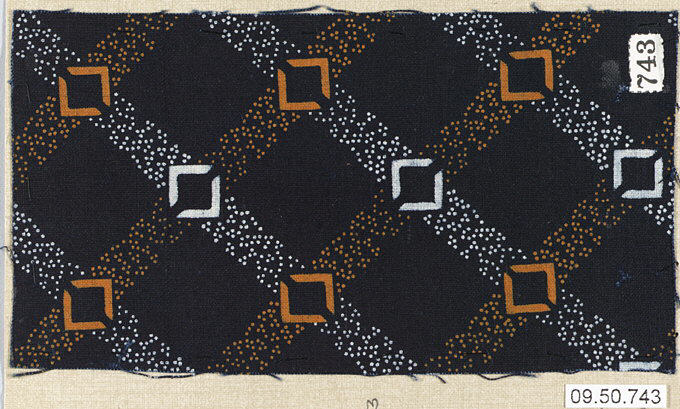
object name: piece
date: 1801-1900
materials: cotton